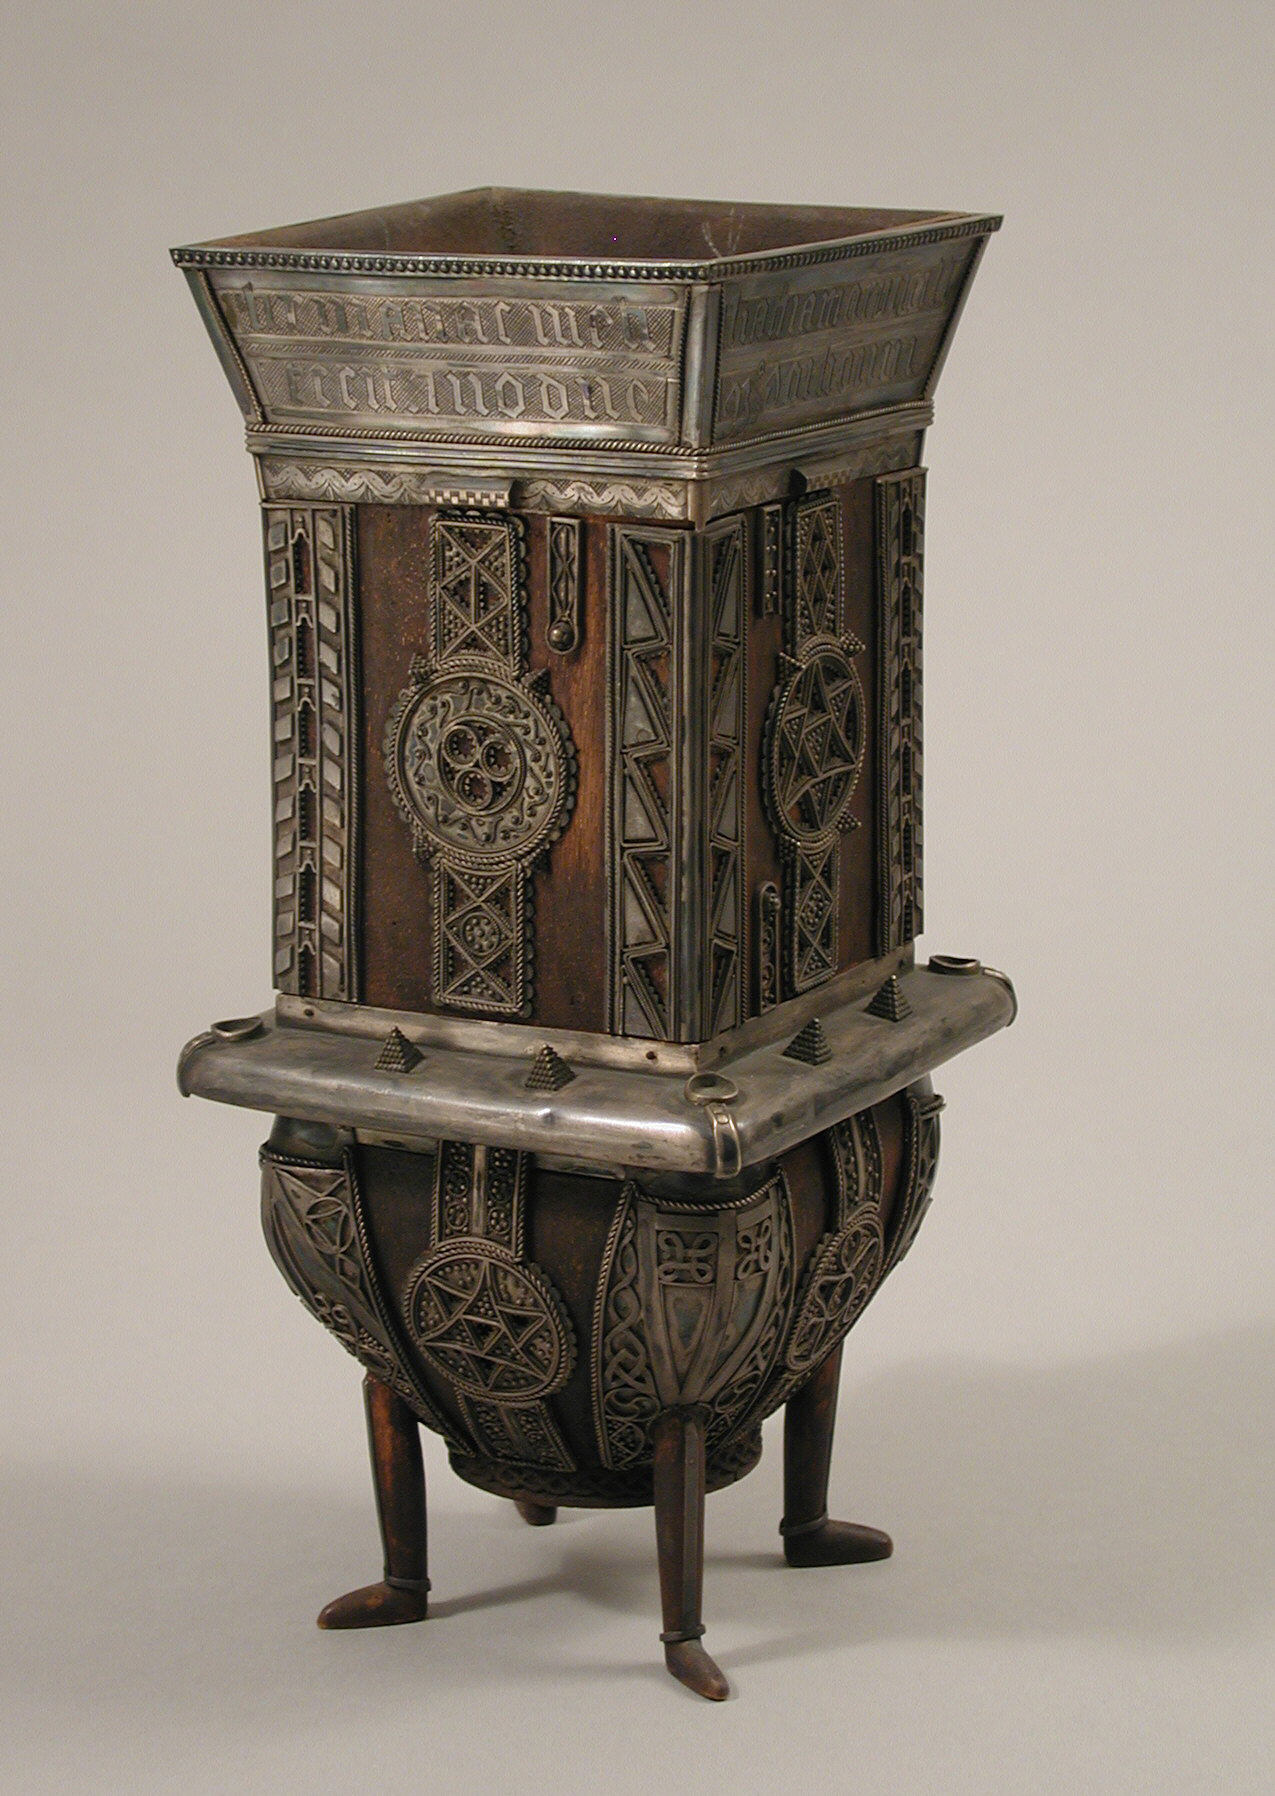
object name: cup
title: Dunvegan Cup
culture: irish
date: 1901-1933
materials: silver, wood